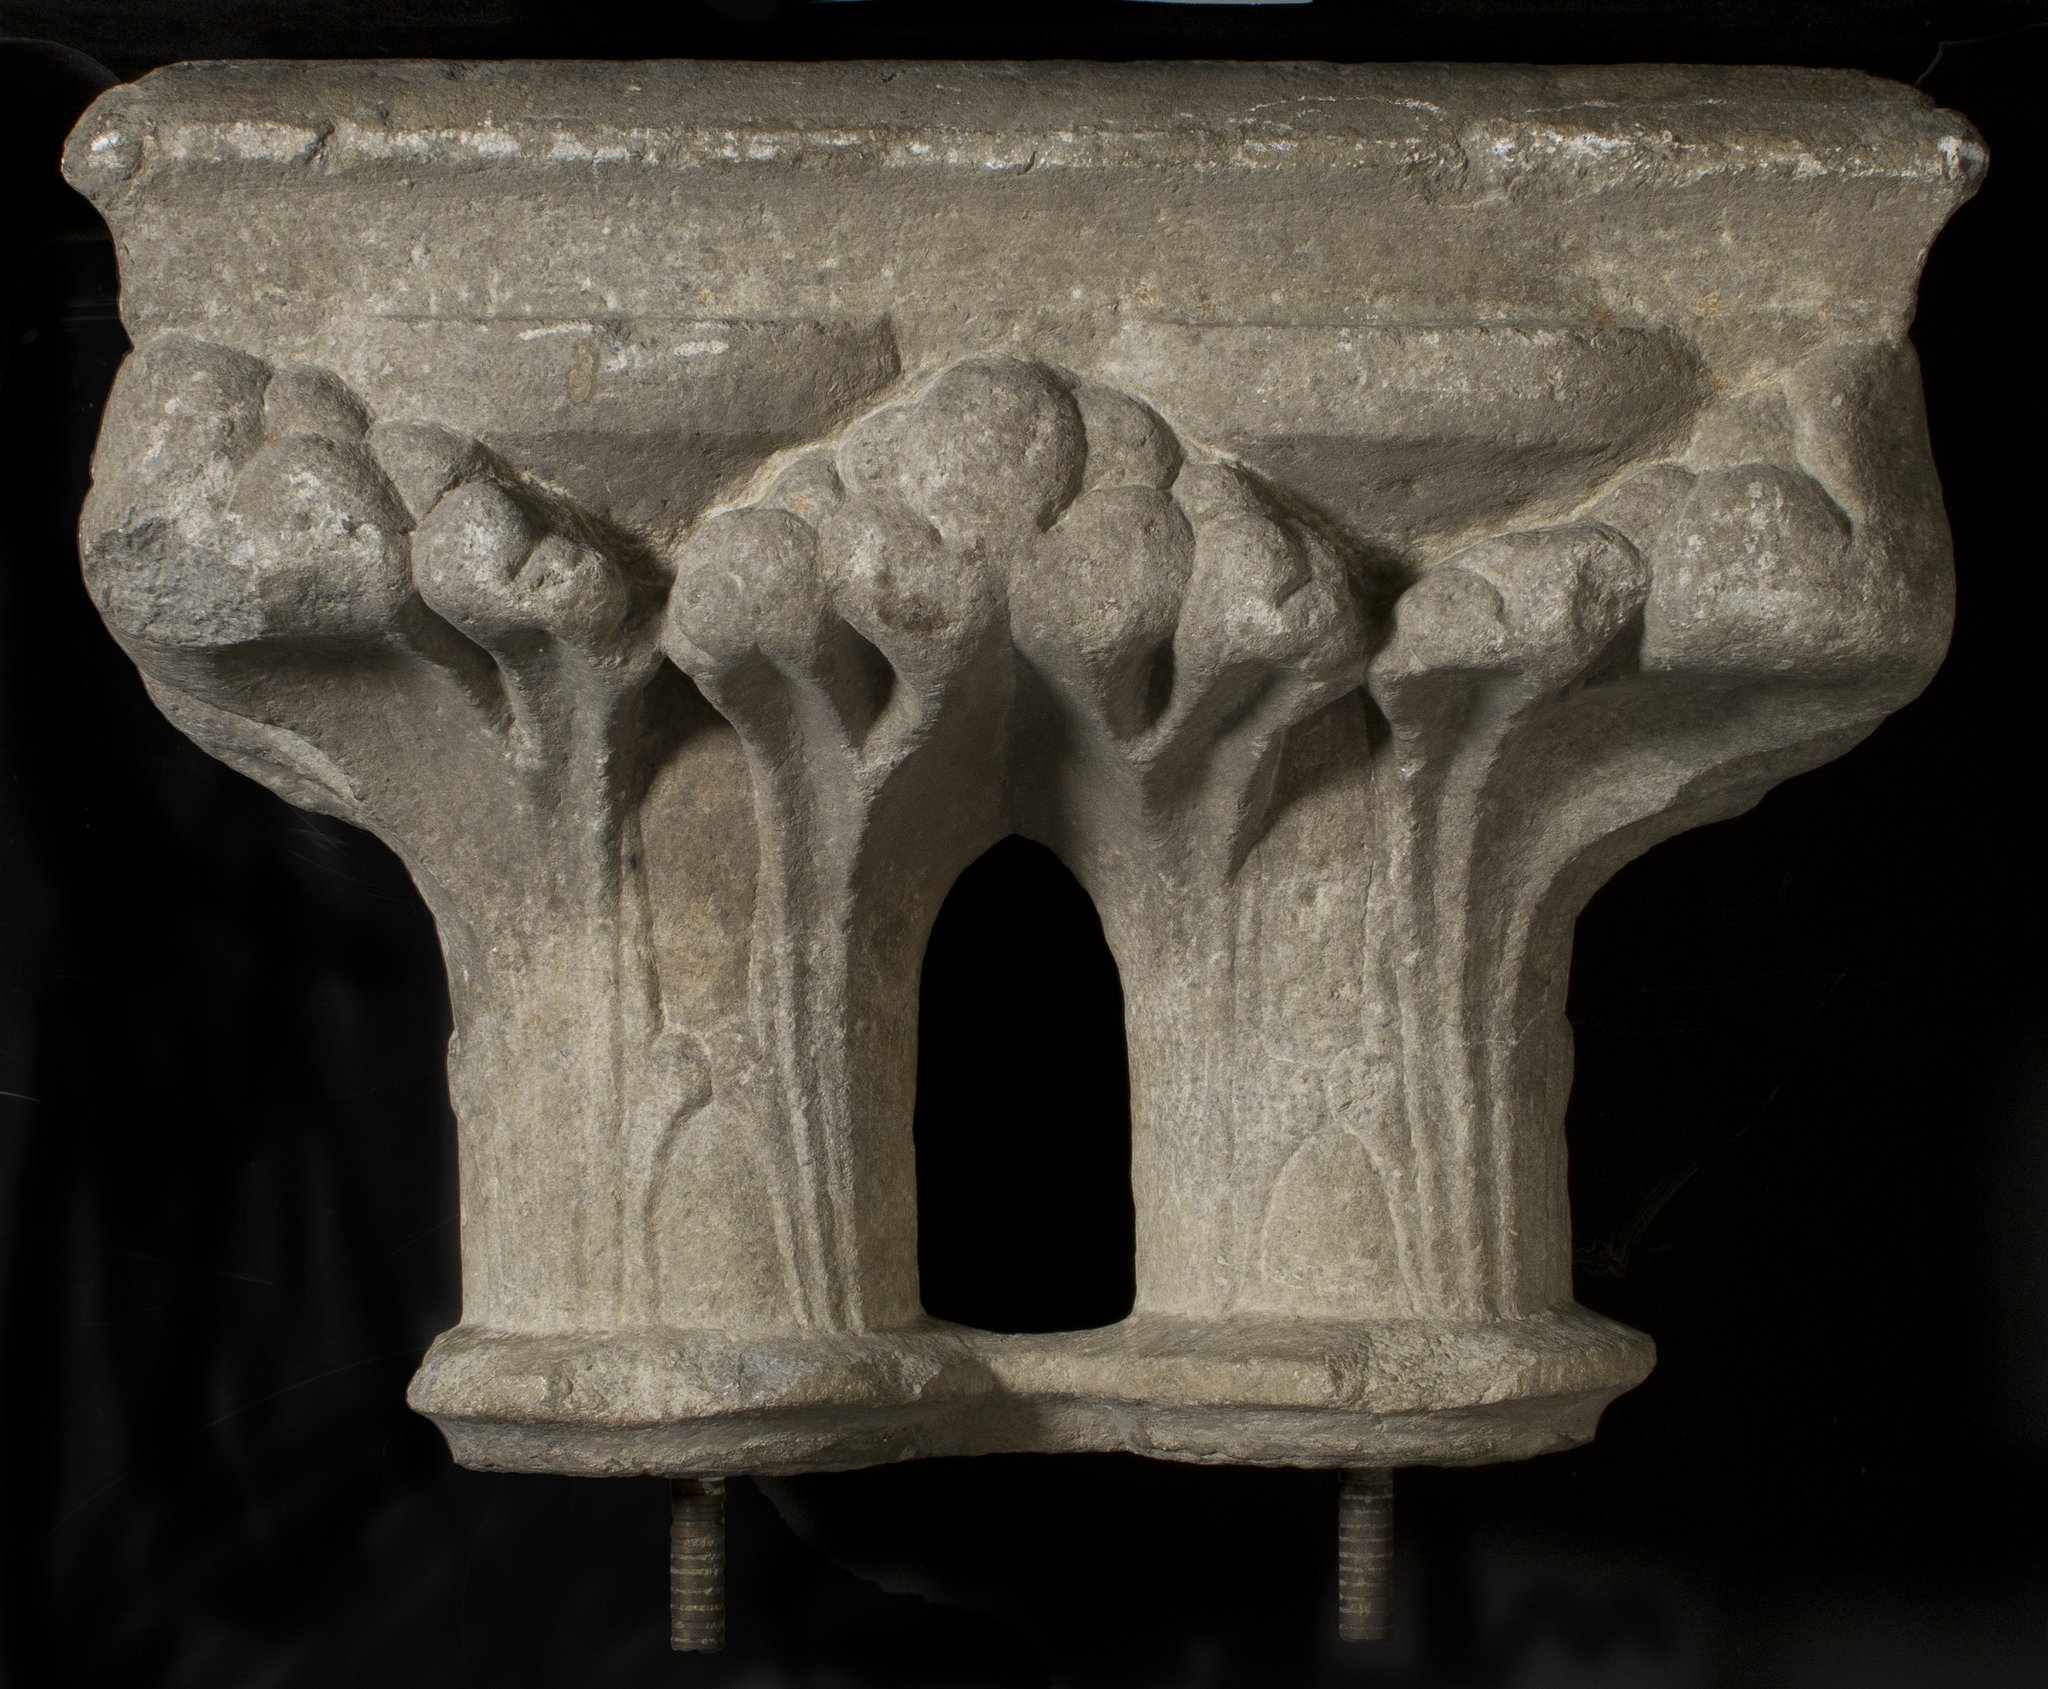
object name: double column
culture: french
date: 1201-1400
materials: marble